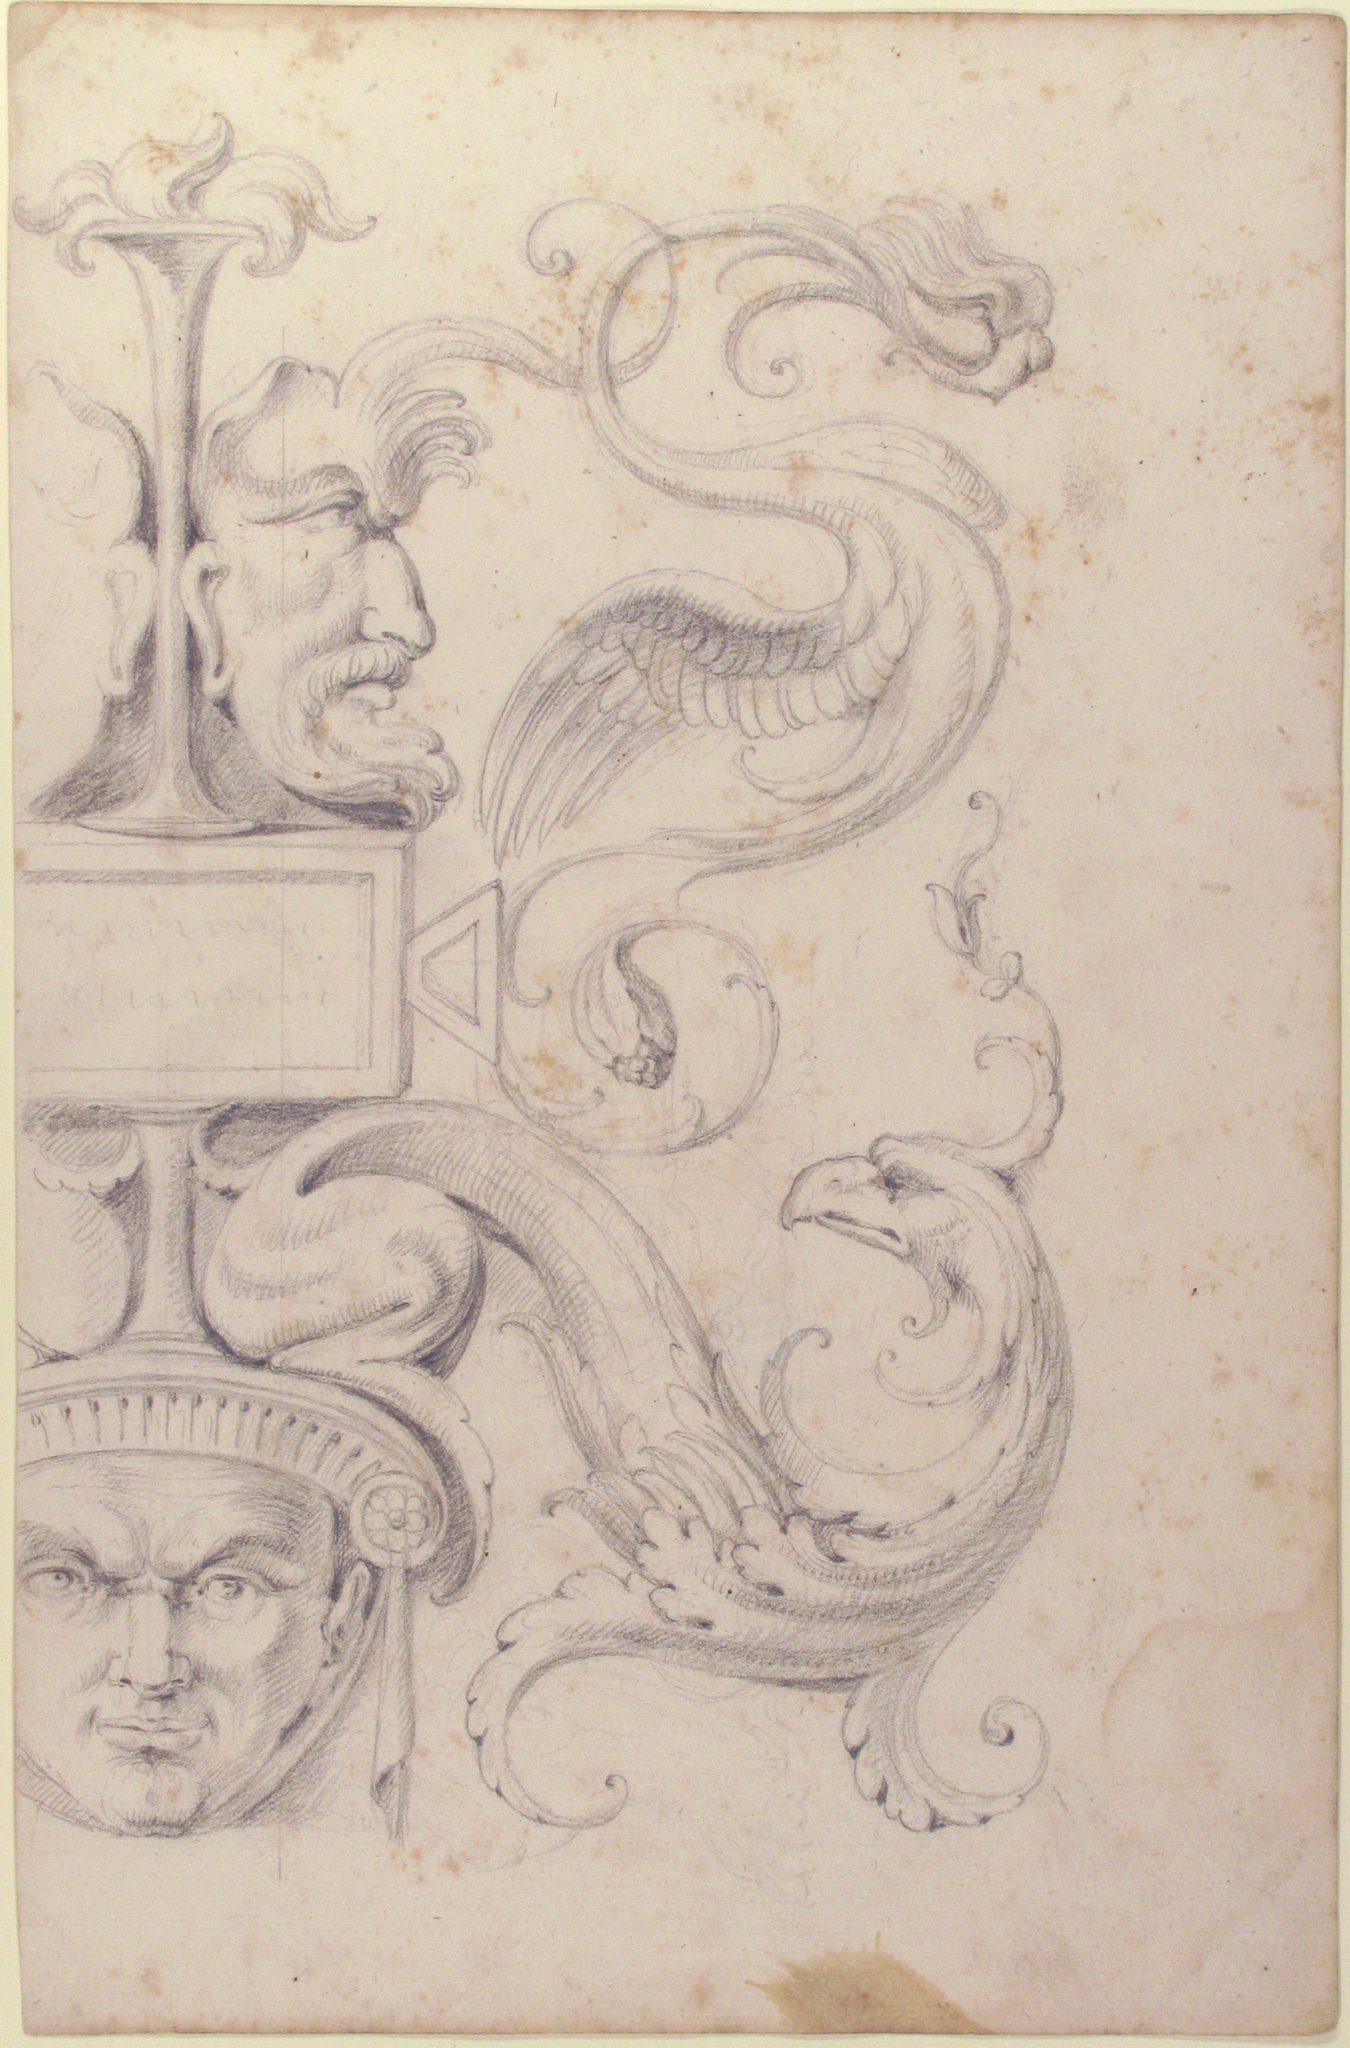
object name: drawing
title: Drawing of a Grotesque after a 16th-century Decorative Relief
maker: filippo cretoni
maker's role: artist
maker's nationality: italian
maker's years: 18-19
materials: chalk, graphite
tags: grotesques,ornament,mythical creatures